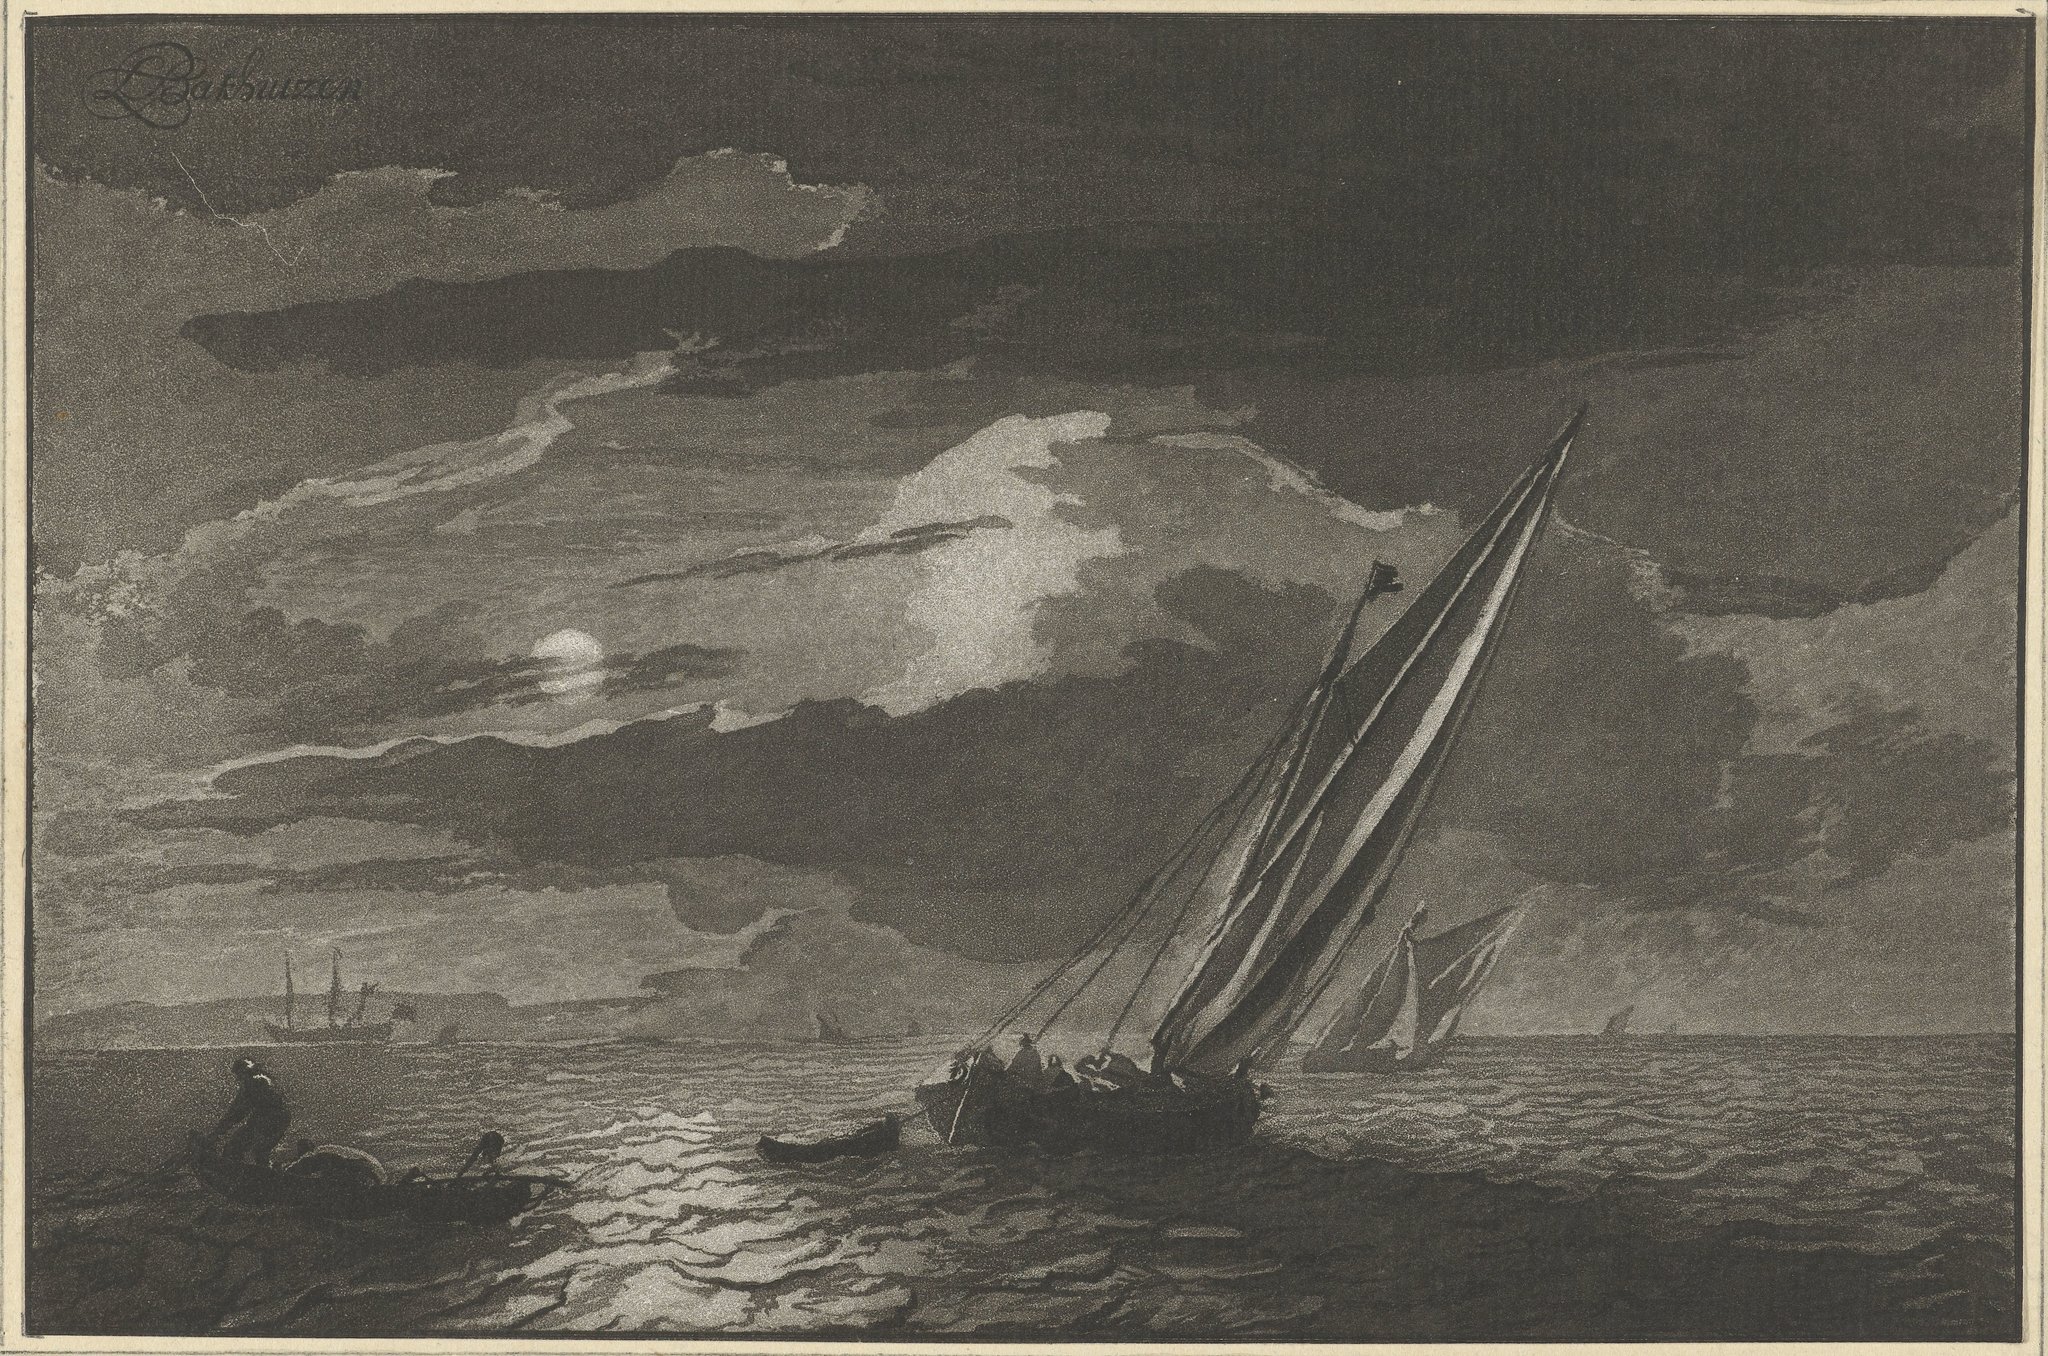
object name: print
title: Zeegezicht met volle maan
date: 1779-1781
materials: paper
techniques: transfer, print drawing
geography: amsterdam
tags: sailing-ship, sailing-boat, moonlight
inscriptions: collector's mark: Lugt 2228, collector's mark: Lugt 1702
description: Op zee varen twee zeilschepen. Een visser haalt vanuit een sloep zijn netten binnen.